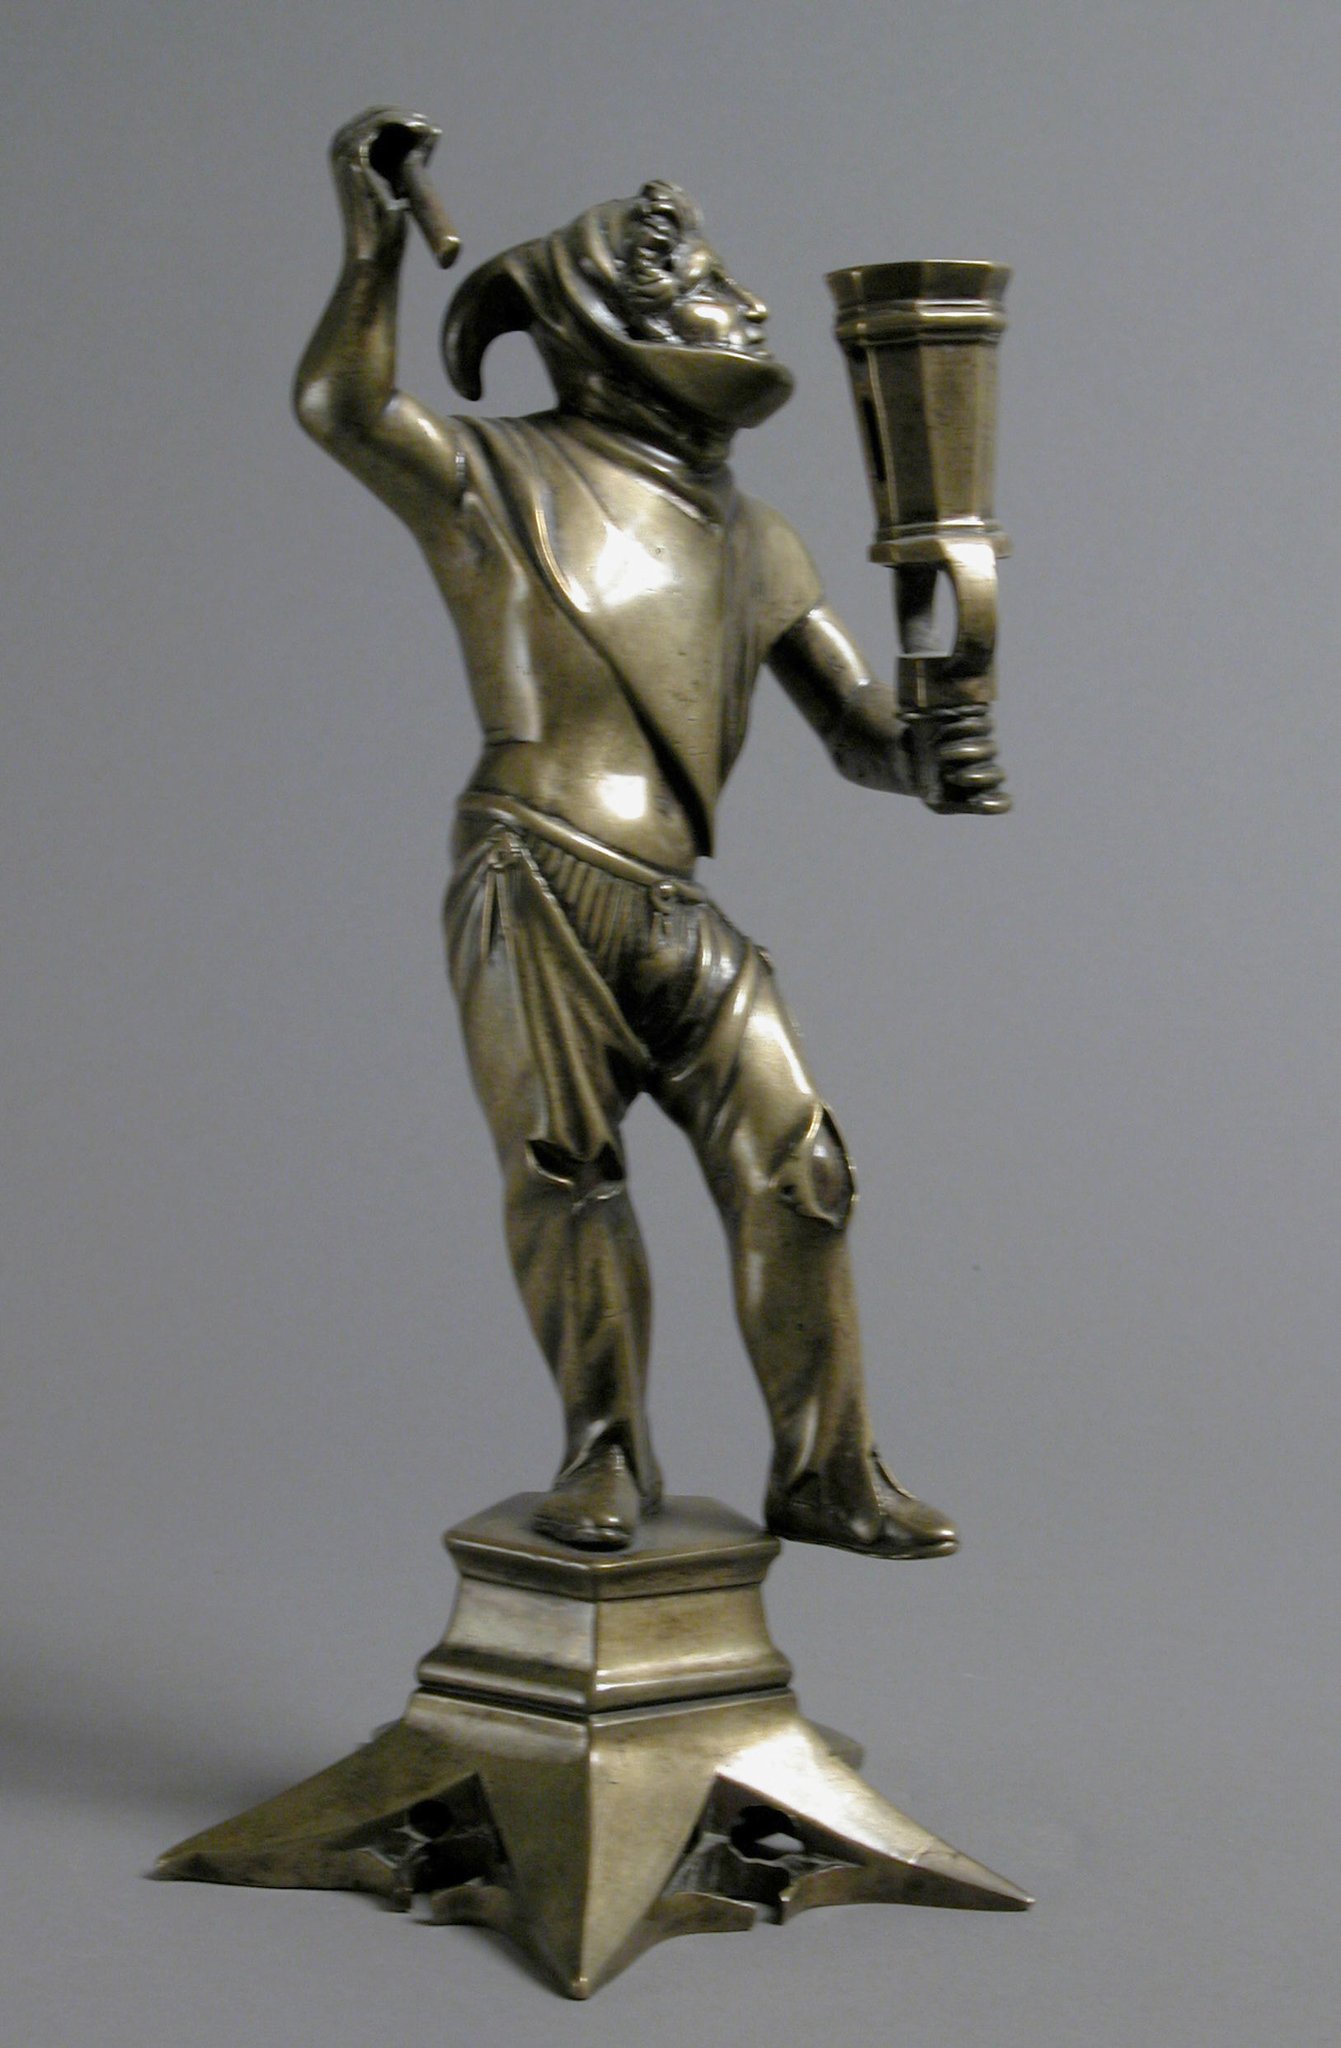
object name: candlestick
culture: south netherlandish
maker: jehan aert van tricht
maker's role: artist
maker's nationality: netherlandish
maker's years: 1492-1501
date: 1500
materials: brass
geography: maastricht or xanten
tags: men